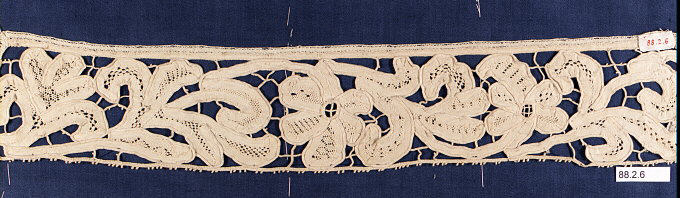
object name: fragment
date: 1601-1800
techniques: lace